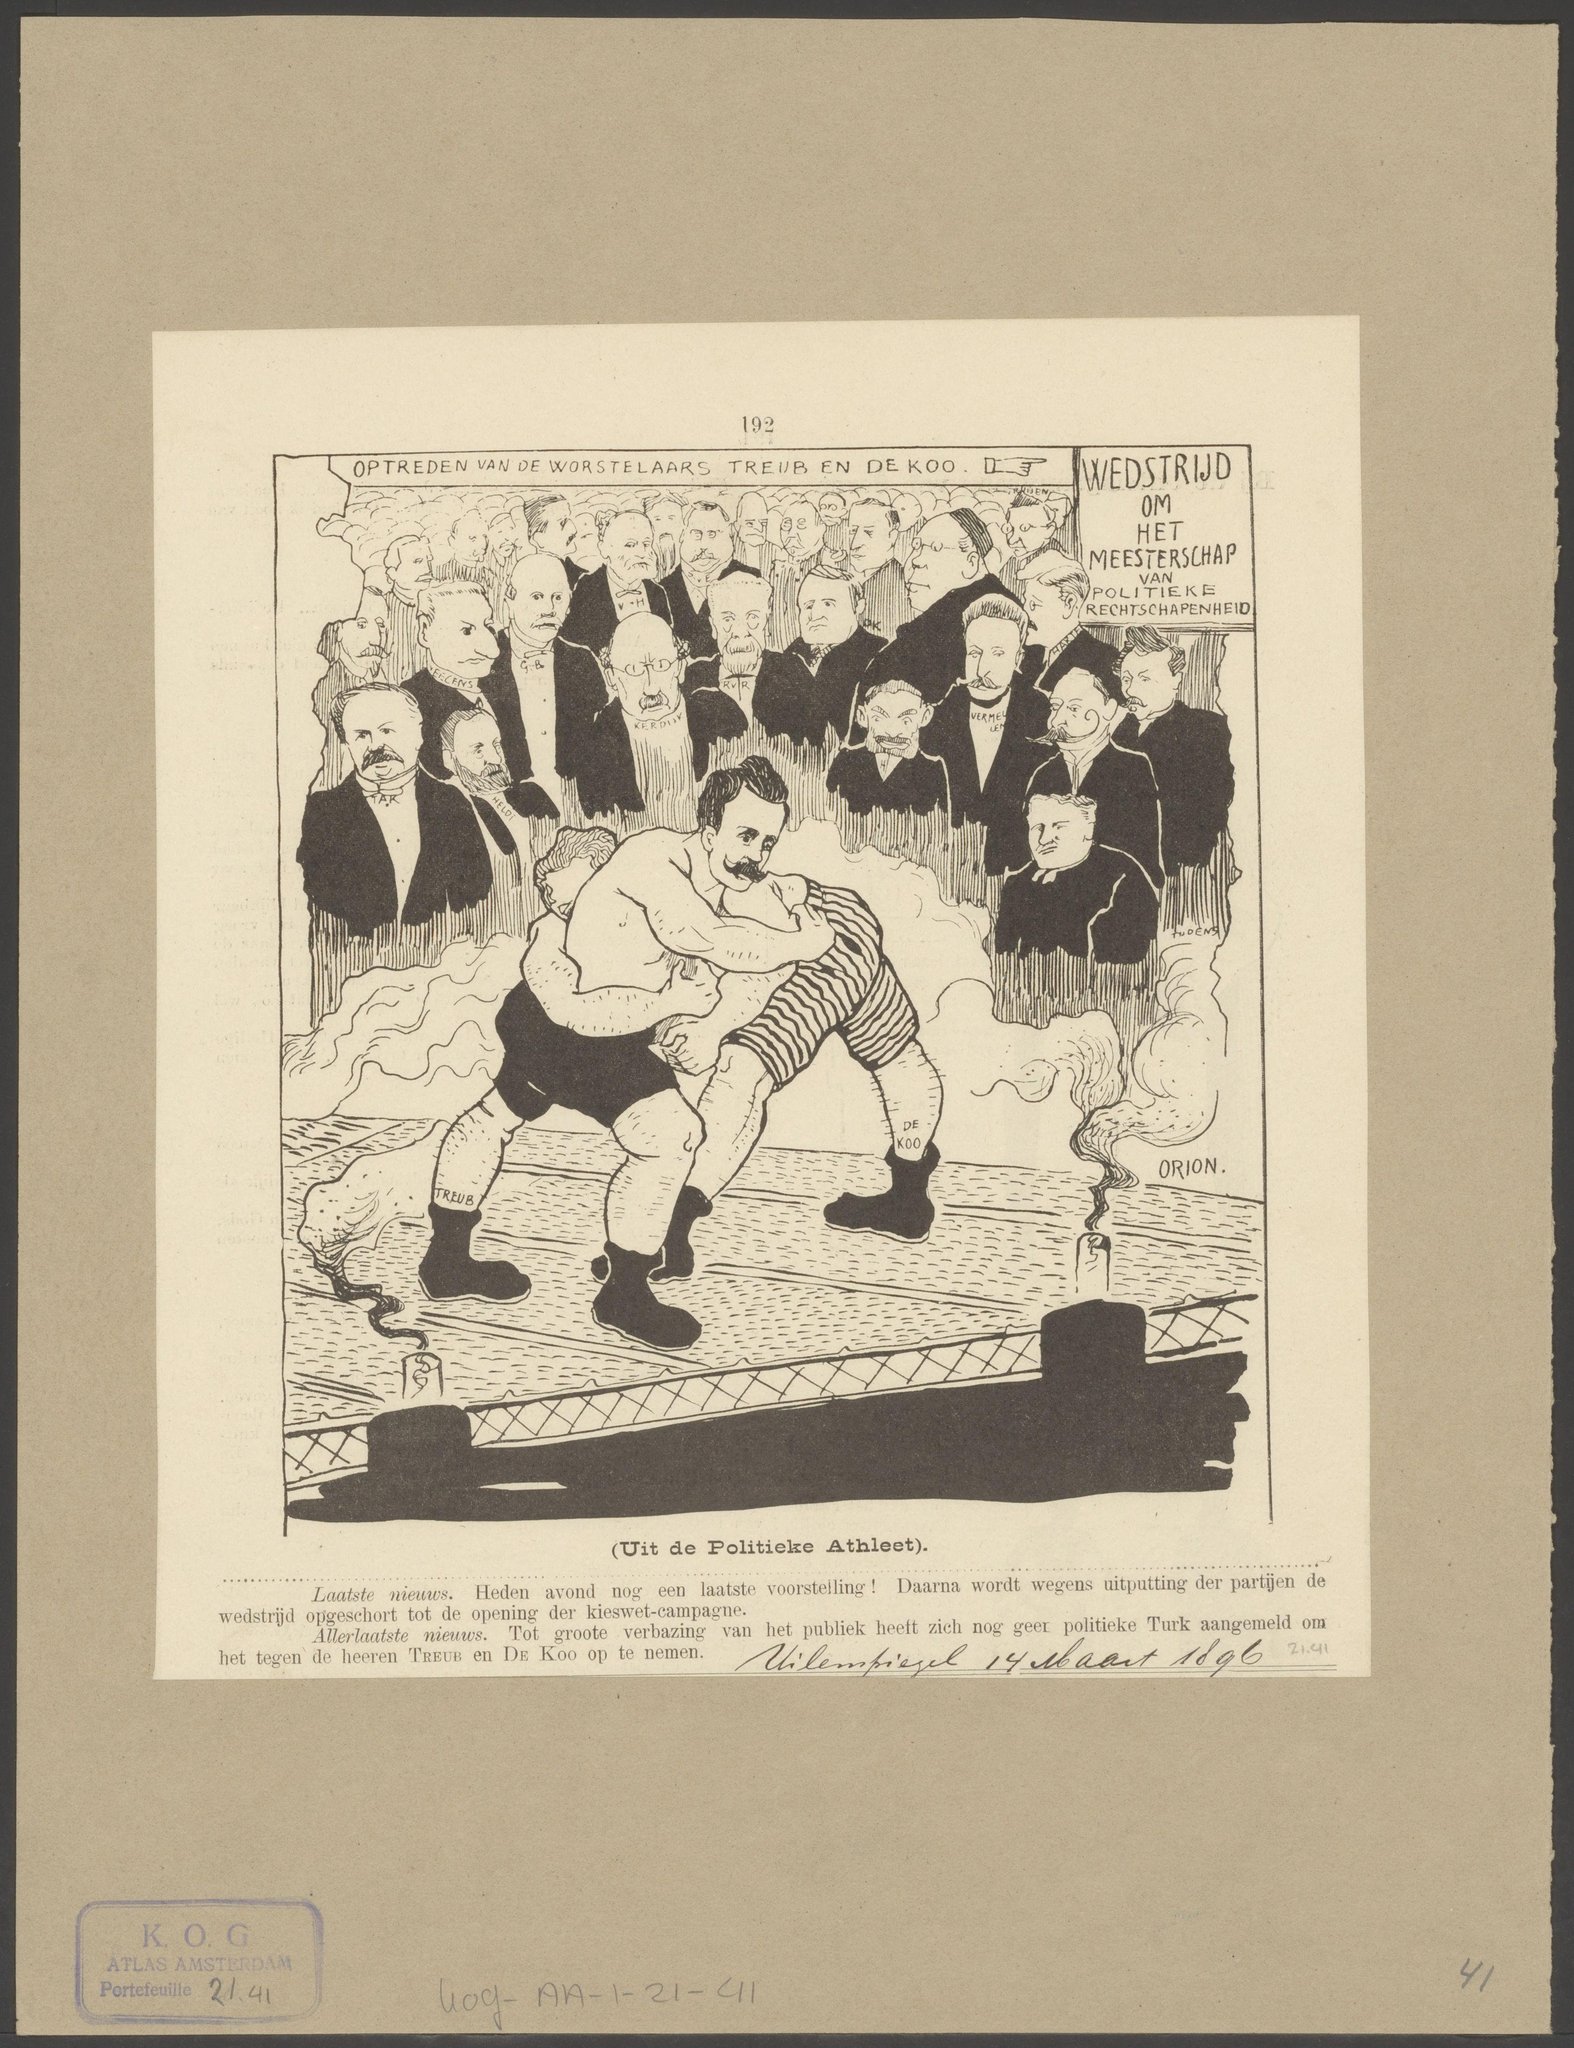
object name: photomechanical print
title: Uit de Politieke Athleet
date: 1896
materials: paper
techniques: letterpress printing, line block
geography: netherlands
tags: delft, politician, amsterdam, arnhem, furniture worker, voorschoten, the hague, johannes de koo, smoke, wrestling (sport), politician, e.g. party leader, political caricatures and satires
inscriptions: collector's mark: Lugt 1641b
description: Onderwerpsrubriek binnen de Atlas Amsterdam: Kiesverenigingen, Politieke partijen.